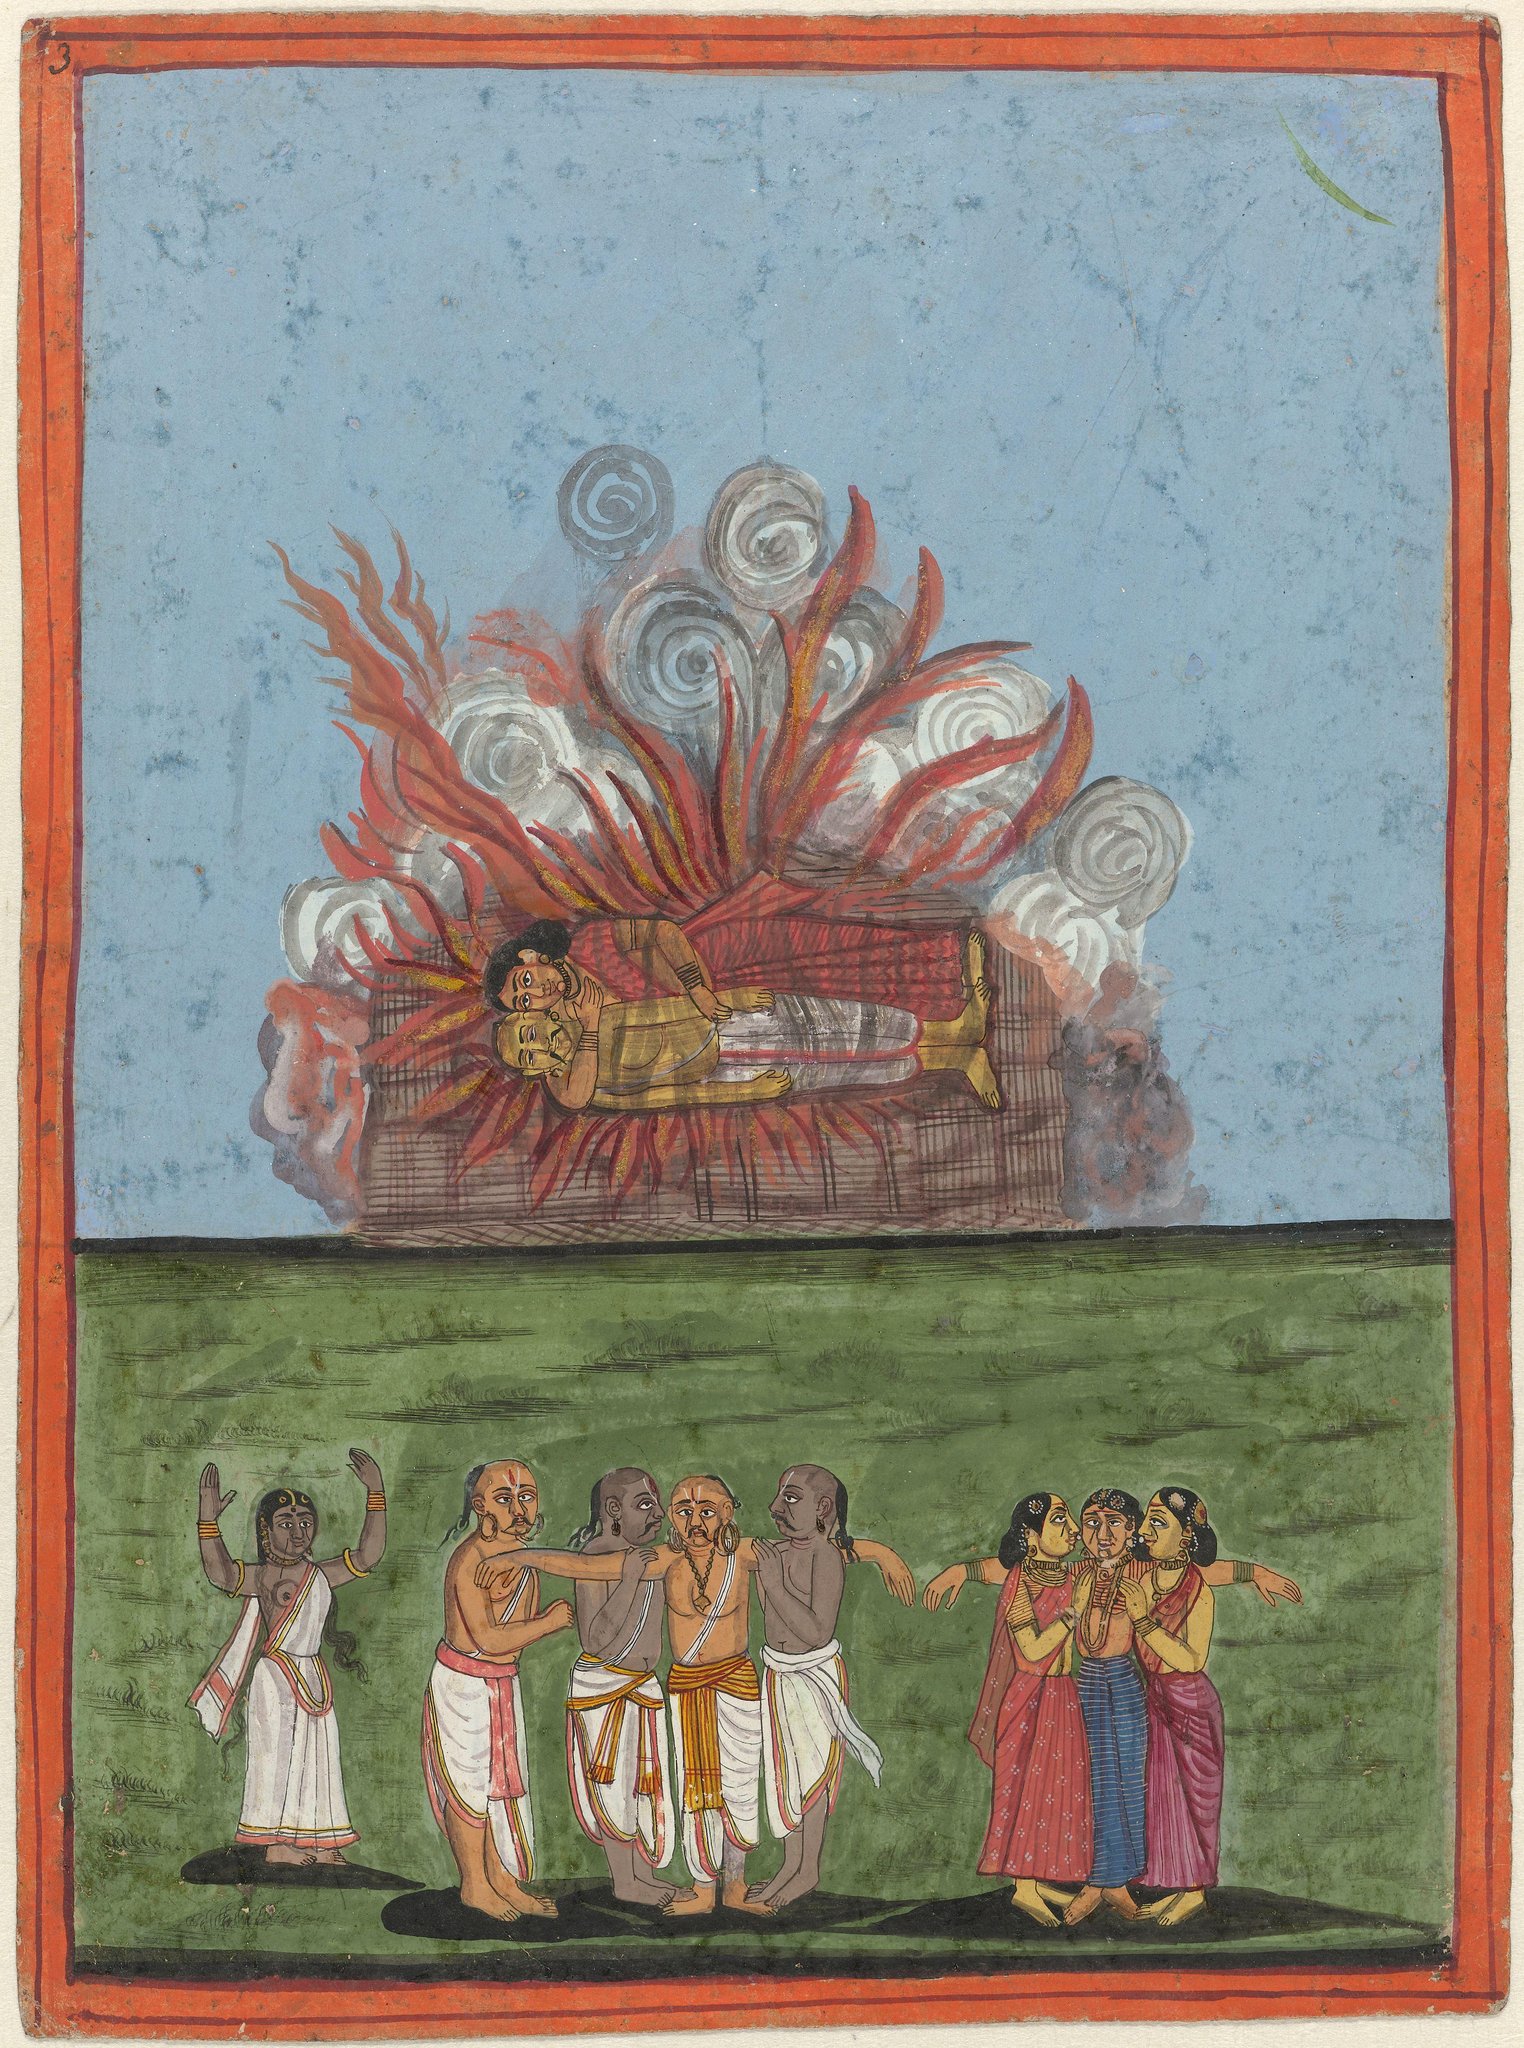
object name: drawing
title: Sati (the practice of burning widows)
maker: Anonymous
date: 1800-1900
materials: paper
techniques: brush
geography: chennai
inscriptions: inscription: ‘.’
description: Sati, ‘the virtuous’ in Sanskrit, refers to a custom whereby a widow is burned on the funeral pyre along with the body of her deceased husband. The life of a widow was unimaginably hard and a sati conferred status and fame on her family. British colonisers banned the ritual in 1829. Made for a European client, this painting probably belonged to a set of illustrations of ‘Indian customs.’